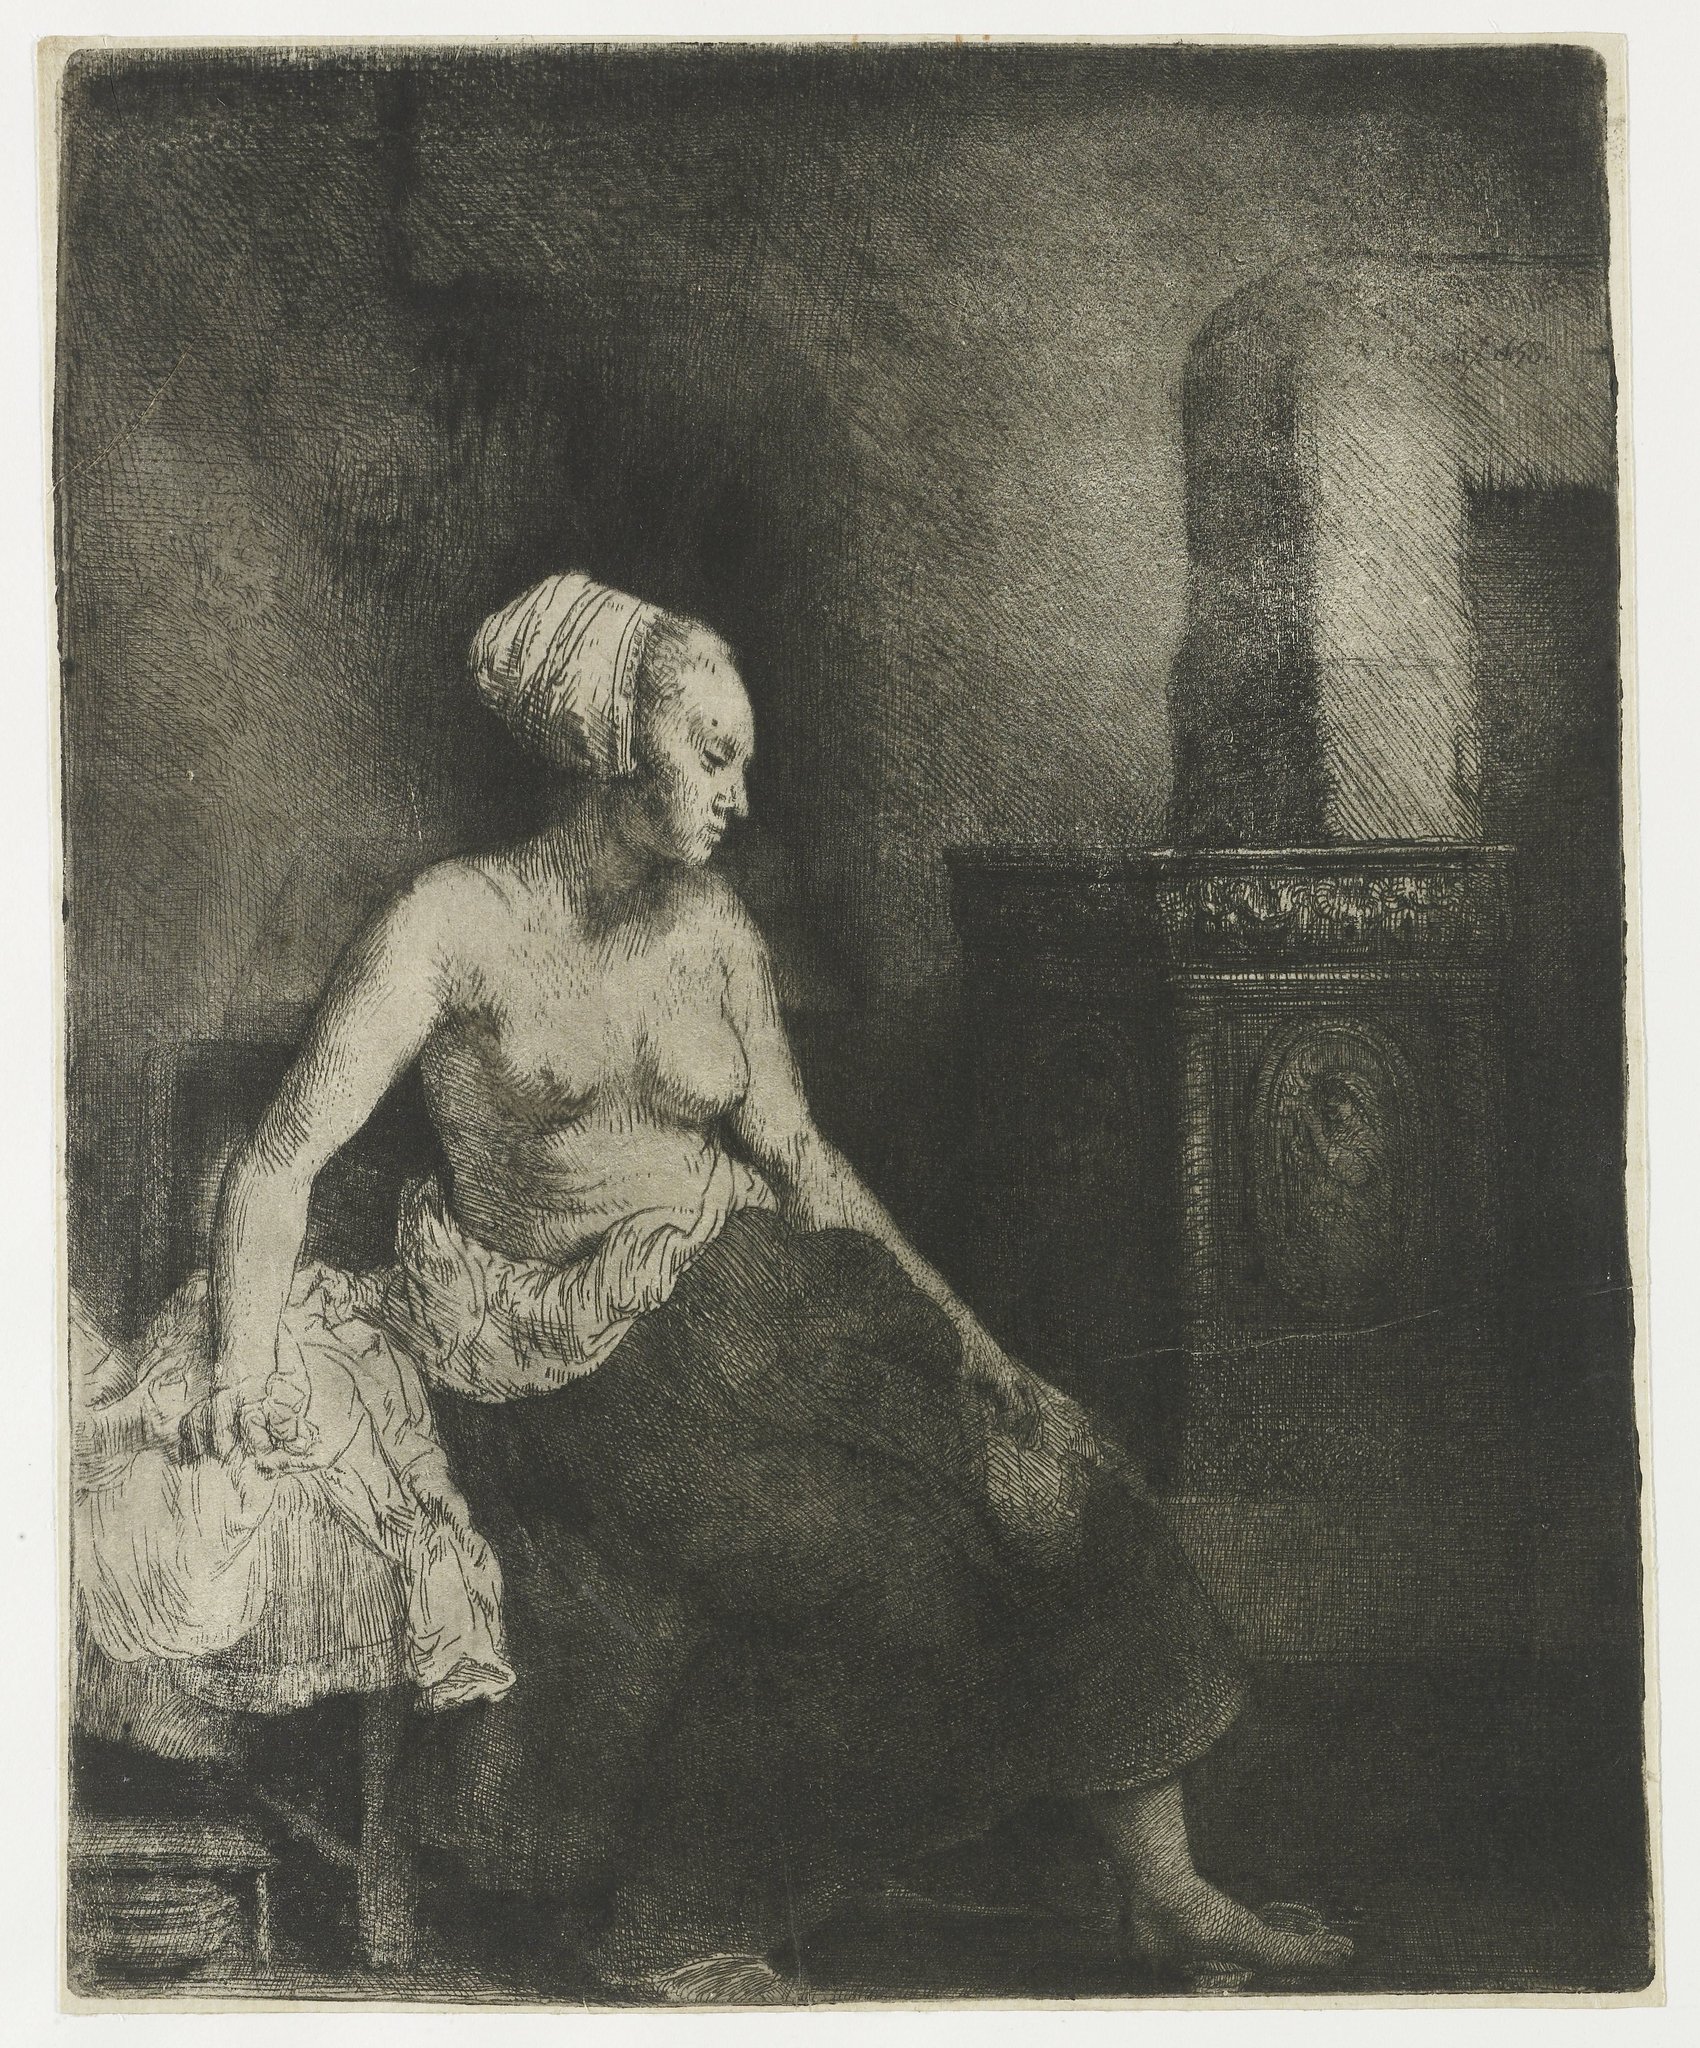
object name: print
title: Woman sitting half dressed beside a stove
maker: rembrandt van rijn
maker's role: draughtsman, painter, print maker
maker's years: 1606-1669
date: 1658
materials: paper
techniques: drypoint, etching, intaglio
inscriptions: signature and date: ‘Rembrandt f. 1658’, collector's mark: Lugt 240